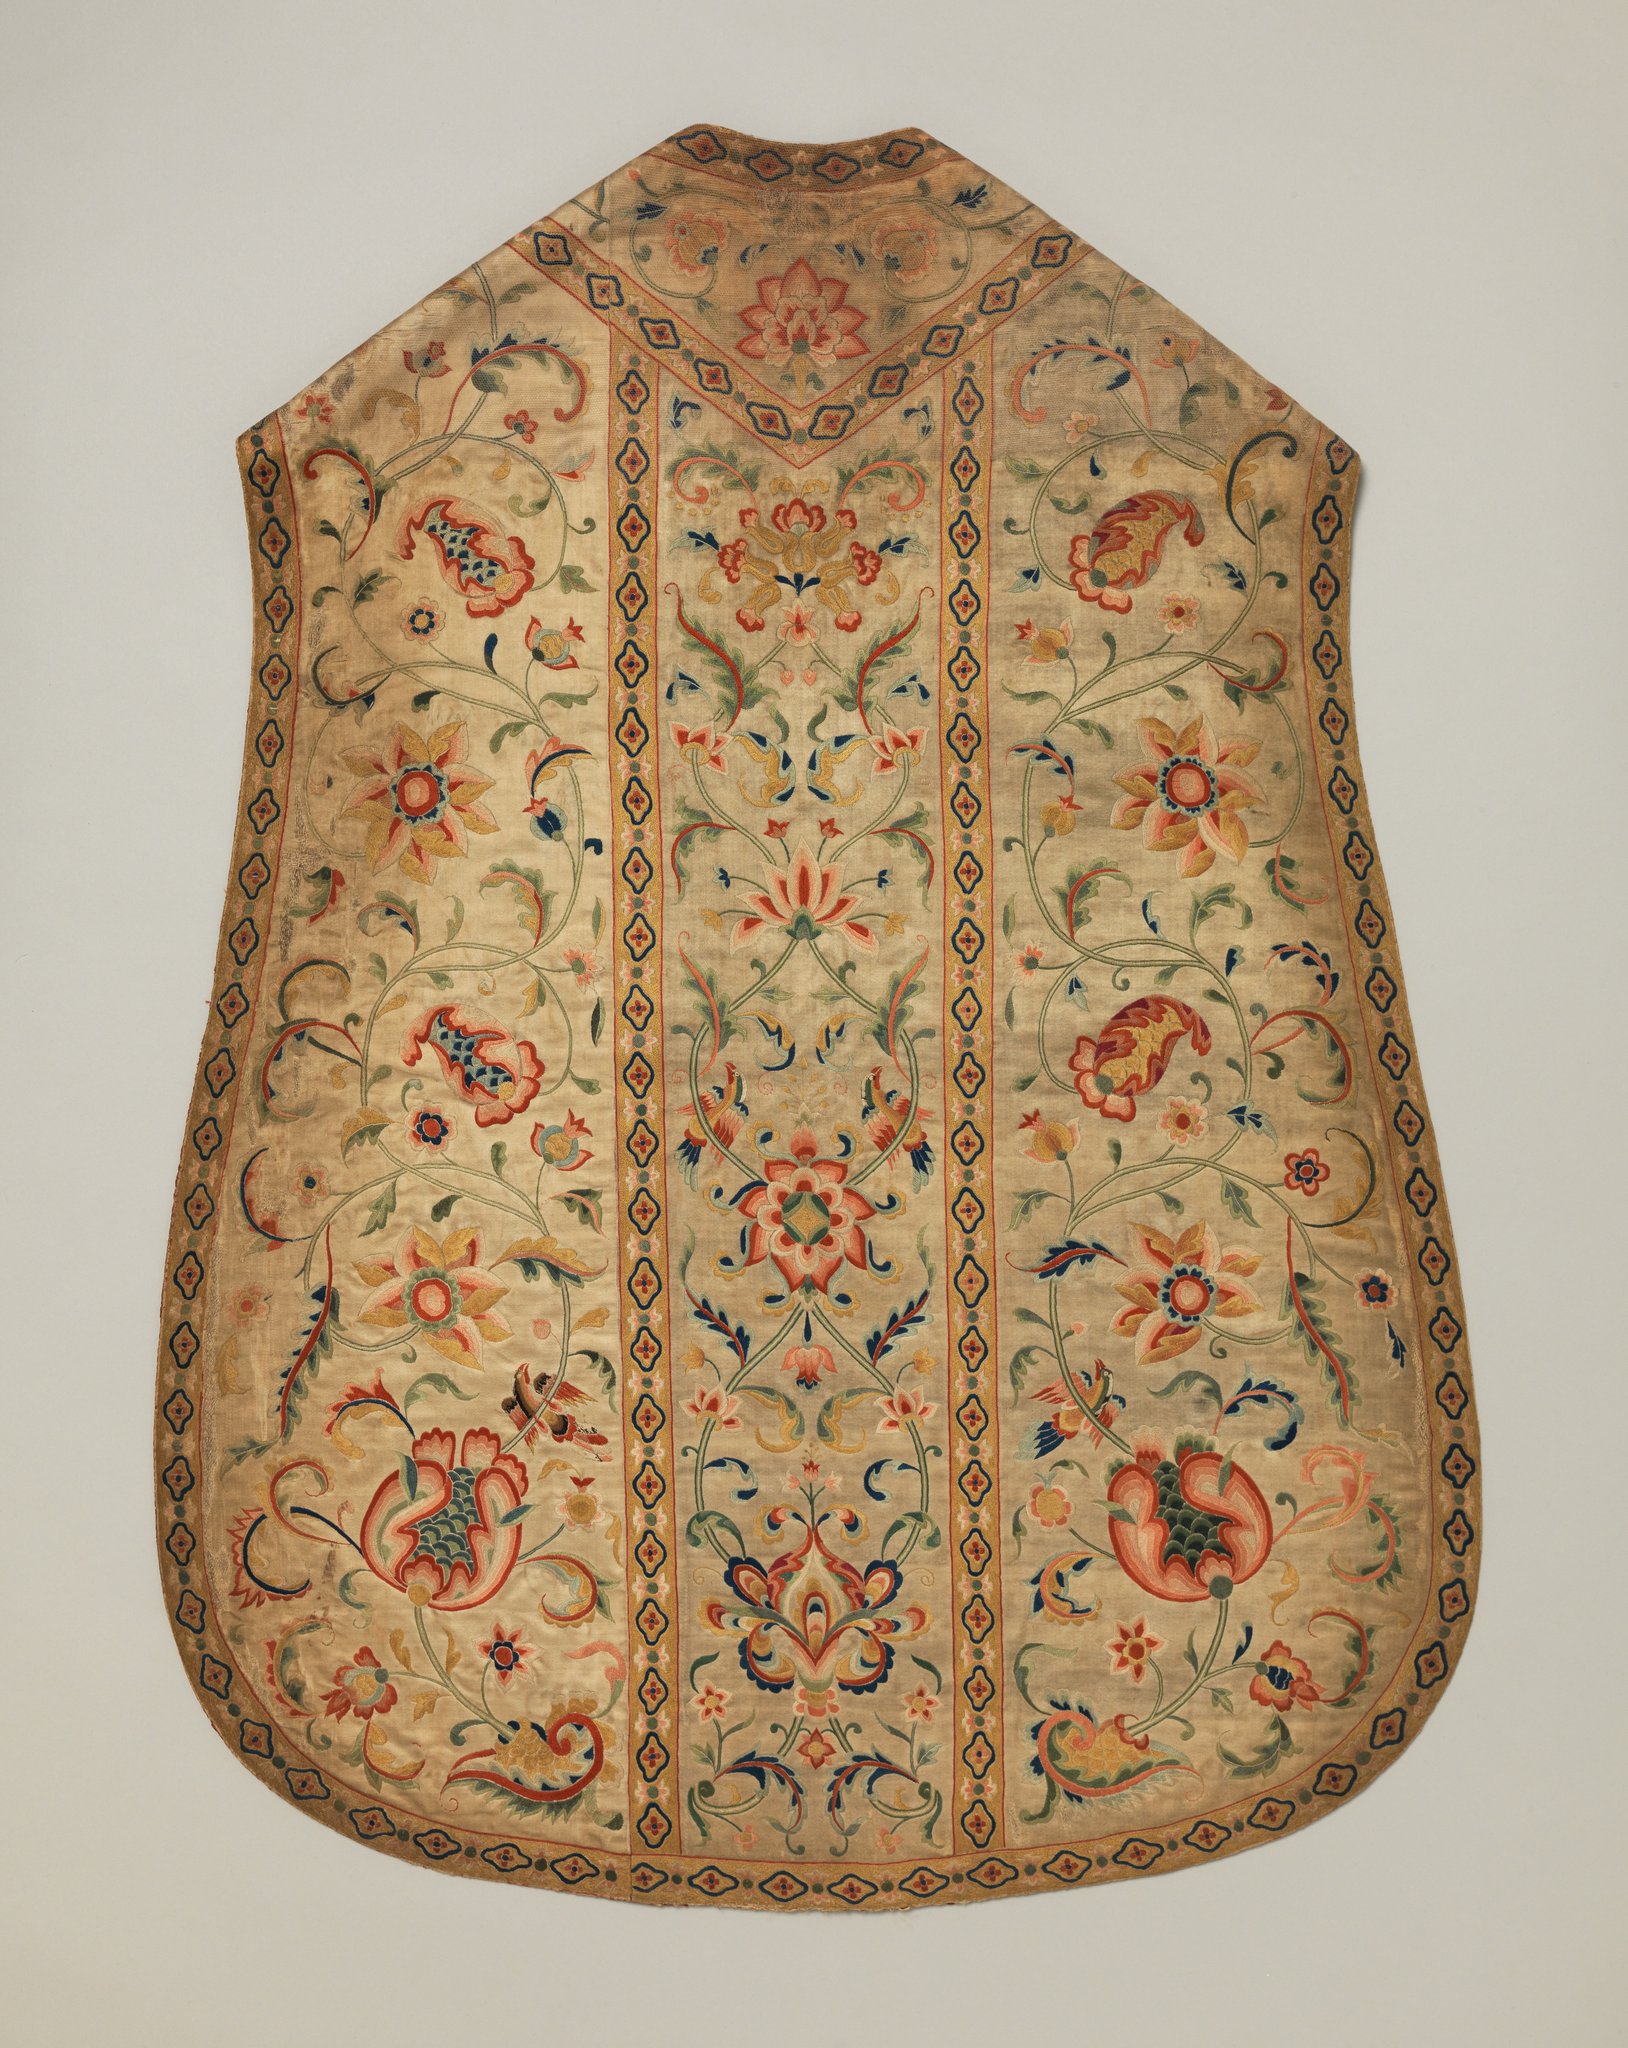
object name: chasuble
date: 1834-1866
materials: silk